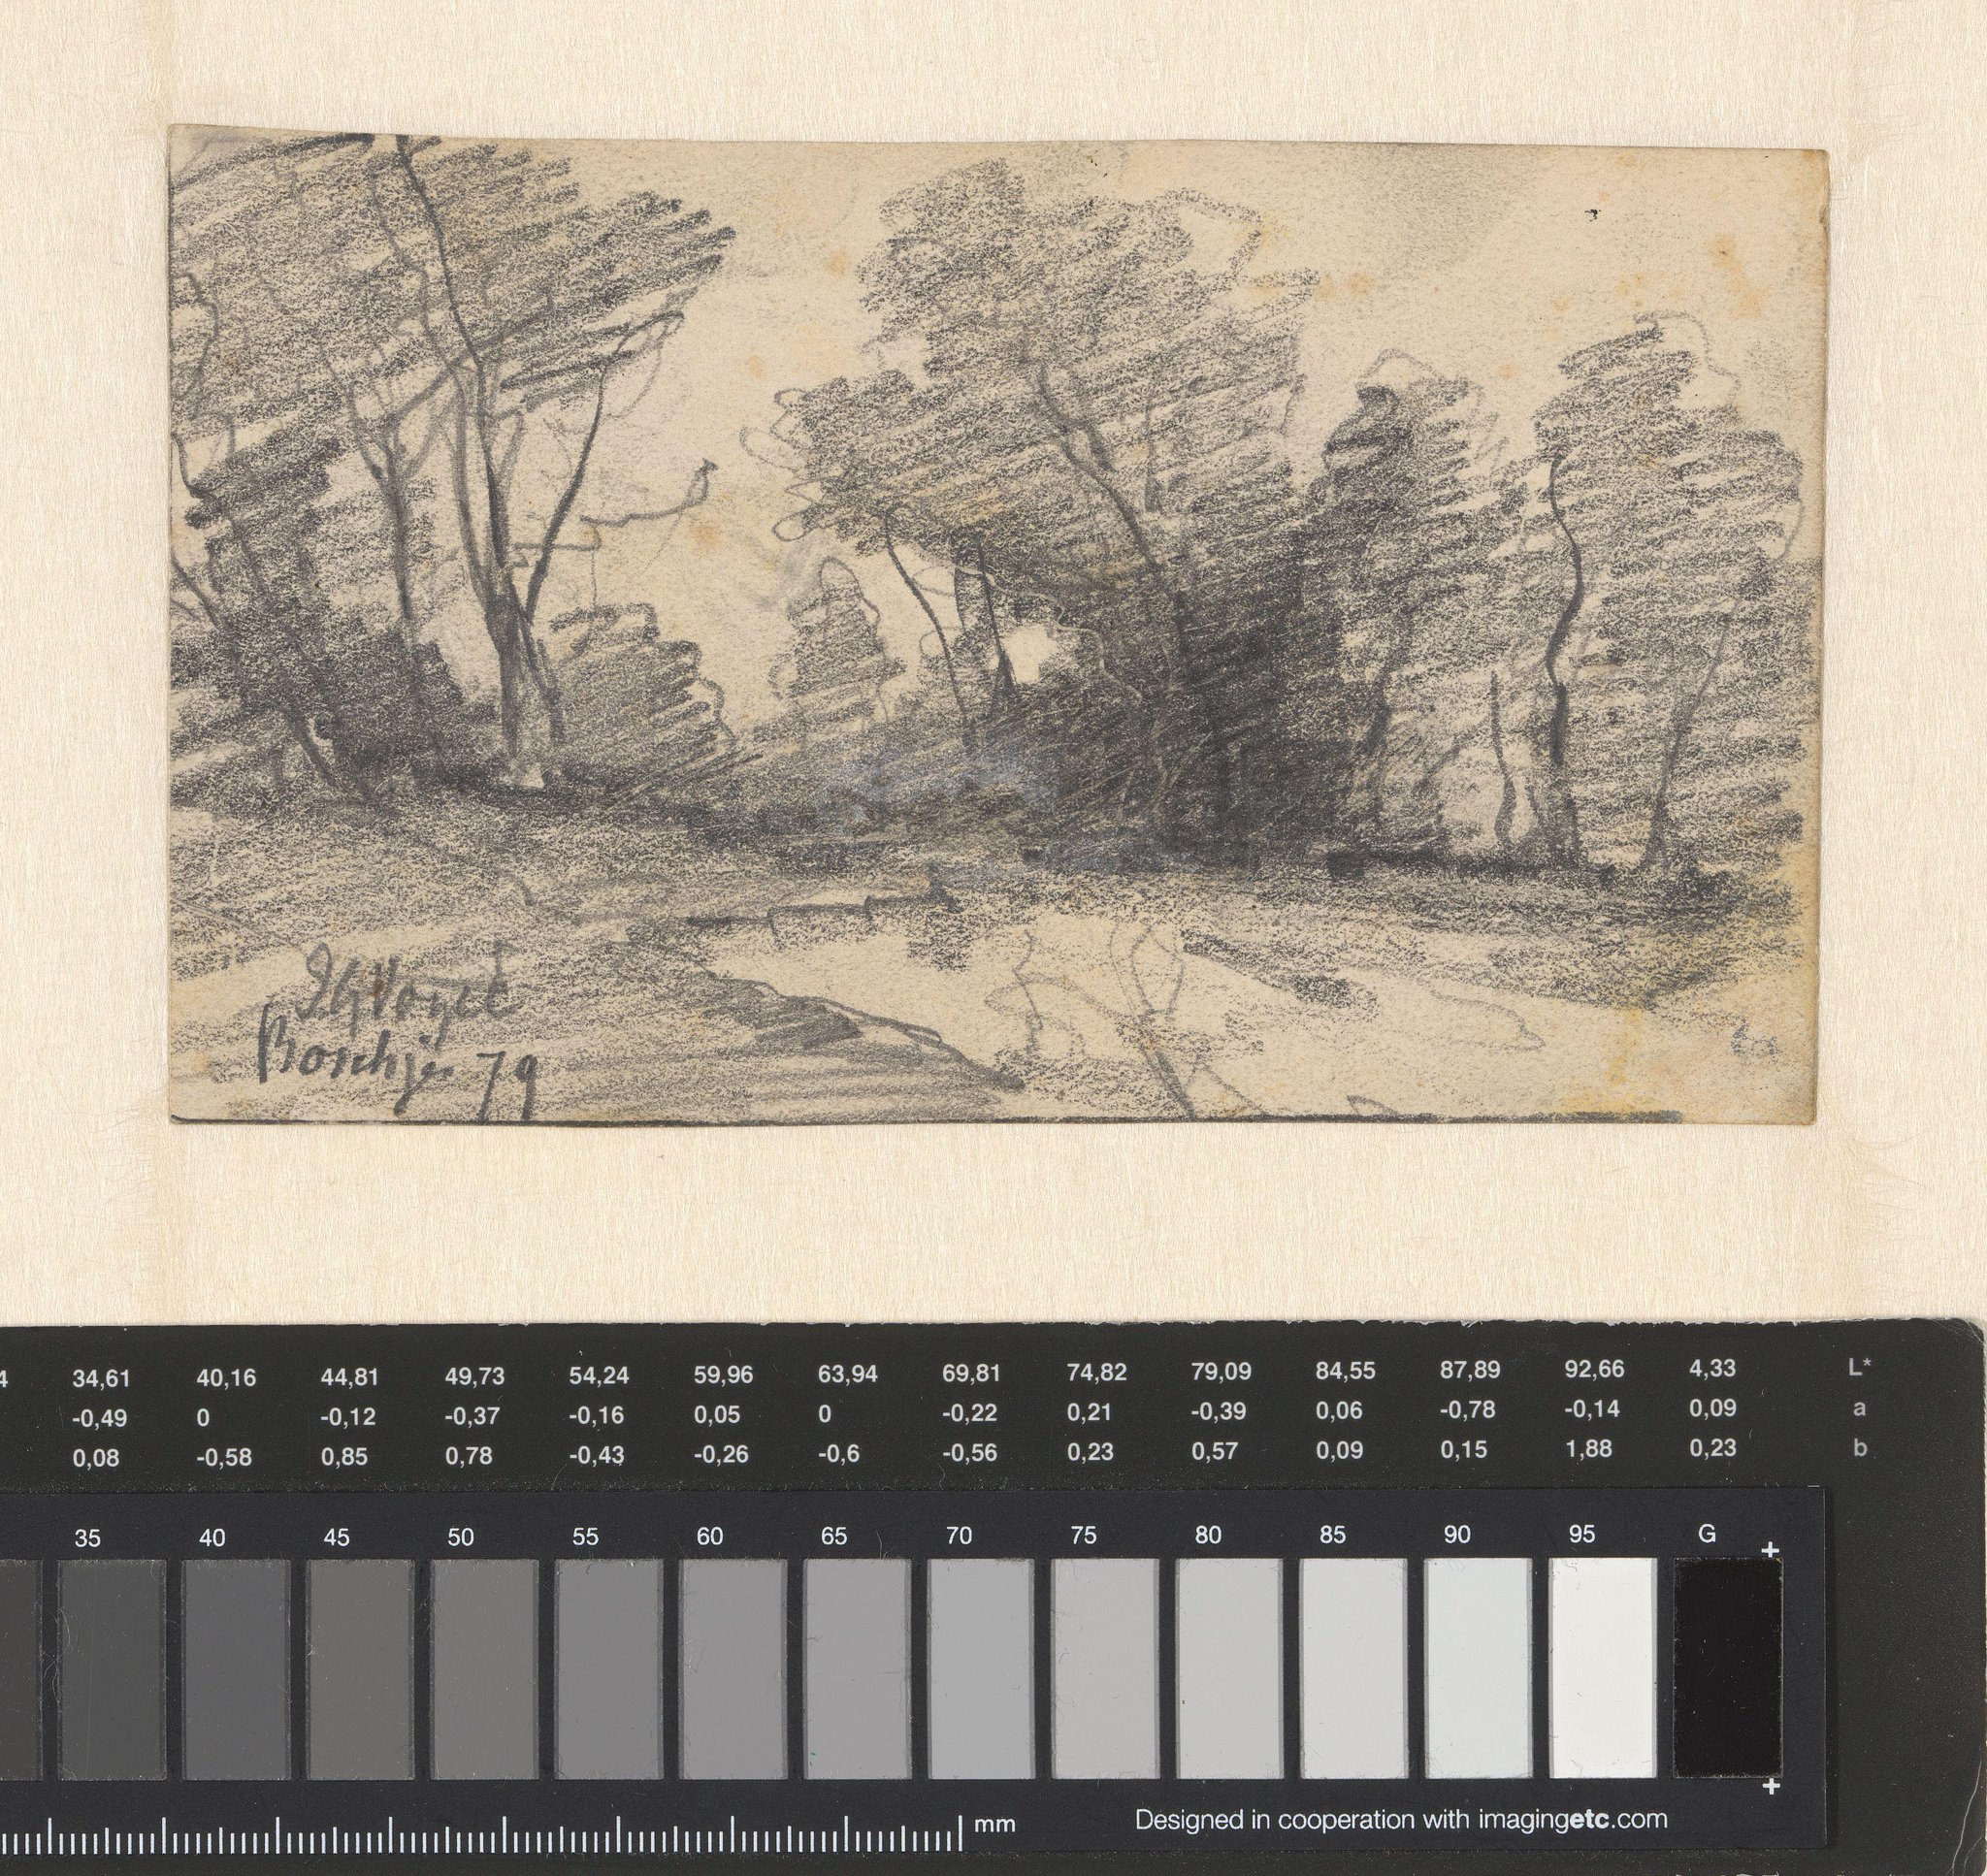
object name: drawing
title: Landschap met bomen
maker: johannes gijsbert vogel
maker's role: draughtsman, painter, print maker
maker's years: 1828-1915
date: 1879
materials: paper, pencil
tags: trees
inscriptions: collector's mark: Lugt 1181b, date and inscription: ‘Boschjes 79’